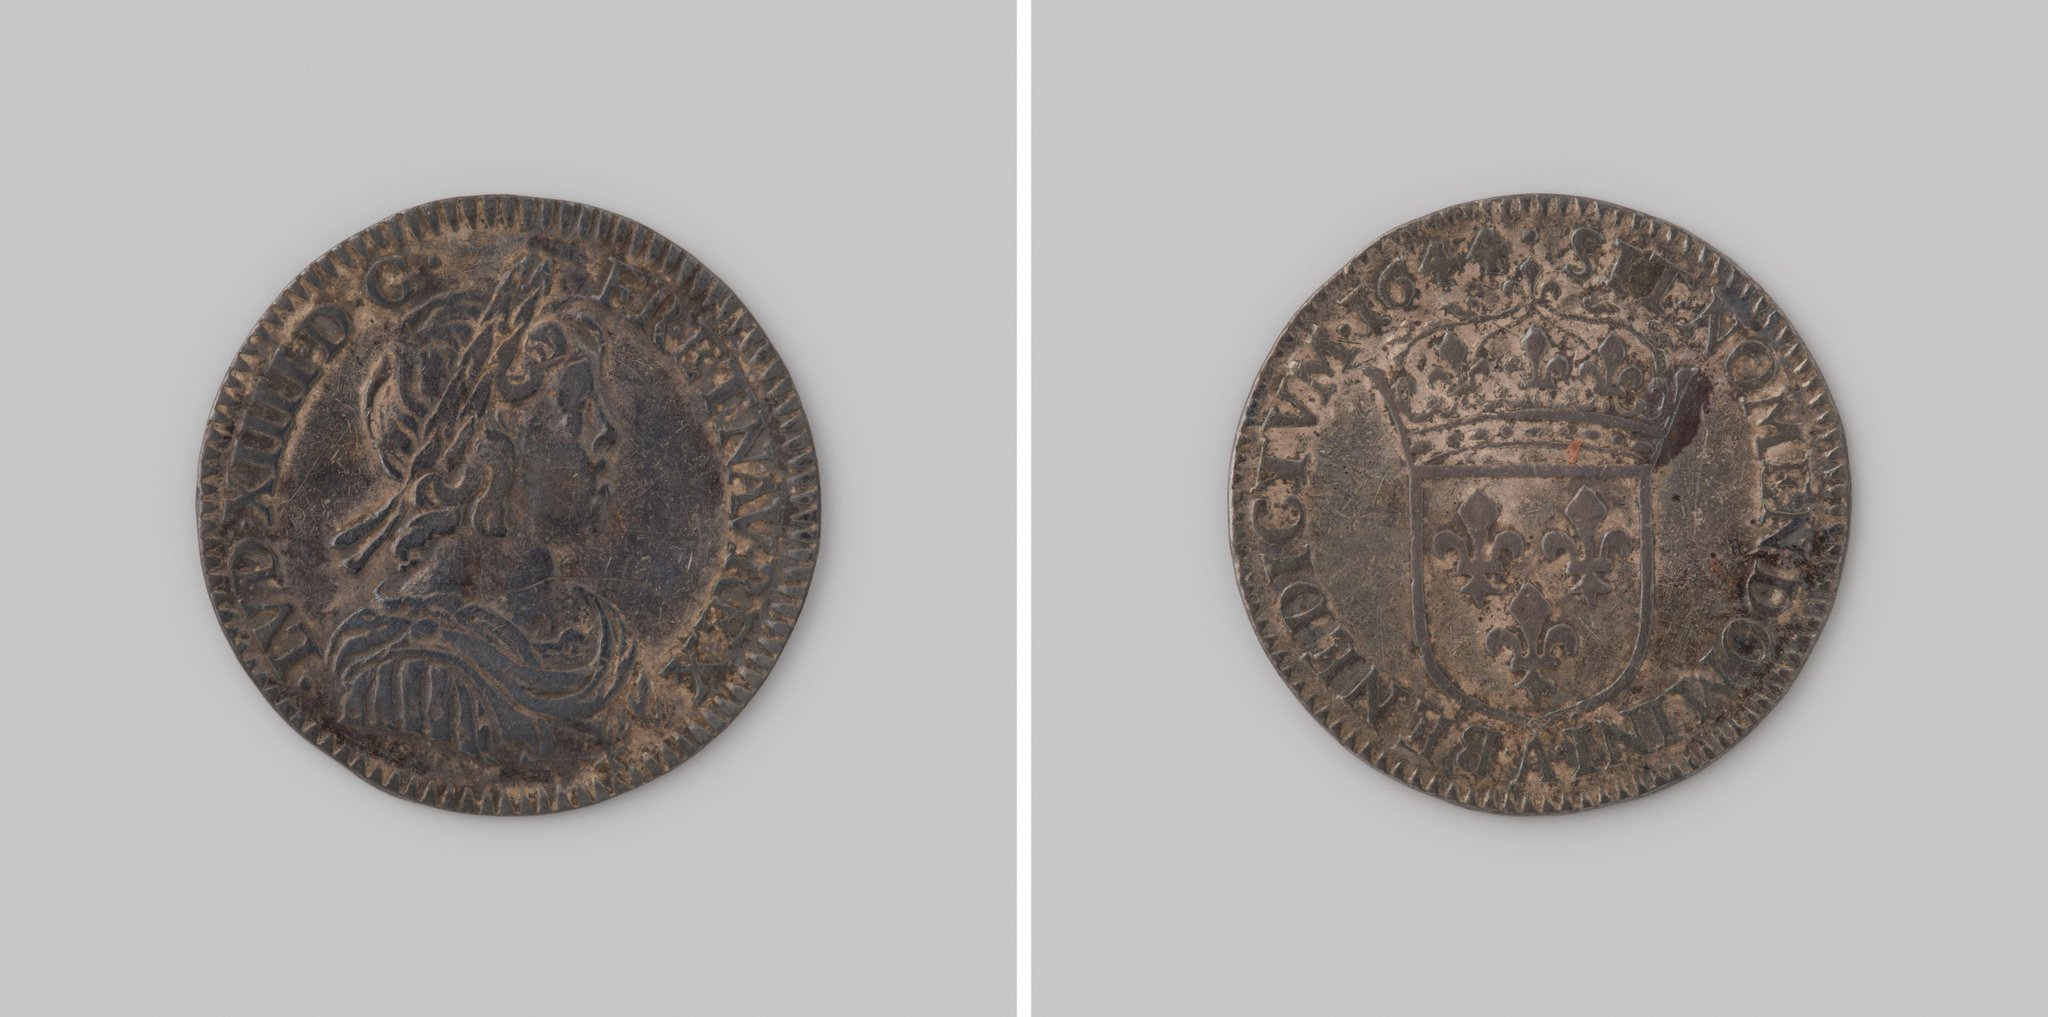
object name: coin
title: 1/12 écu uit Frankrijk van Lodewijk XIV, 1644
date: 1644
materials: silver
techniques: striking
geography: paris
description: Zilveren munt. Voorzijde: gelauwerd borstbeeld van de koning naar rechts. Keerzijde: gekroond wapenschild. Onderaan in omschrift letter A [=Parijs]. Jaartal aan eind van omschrift.